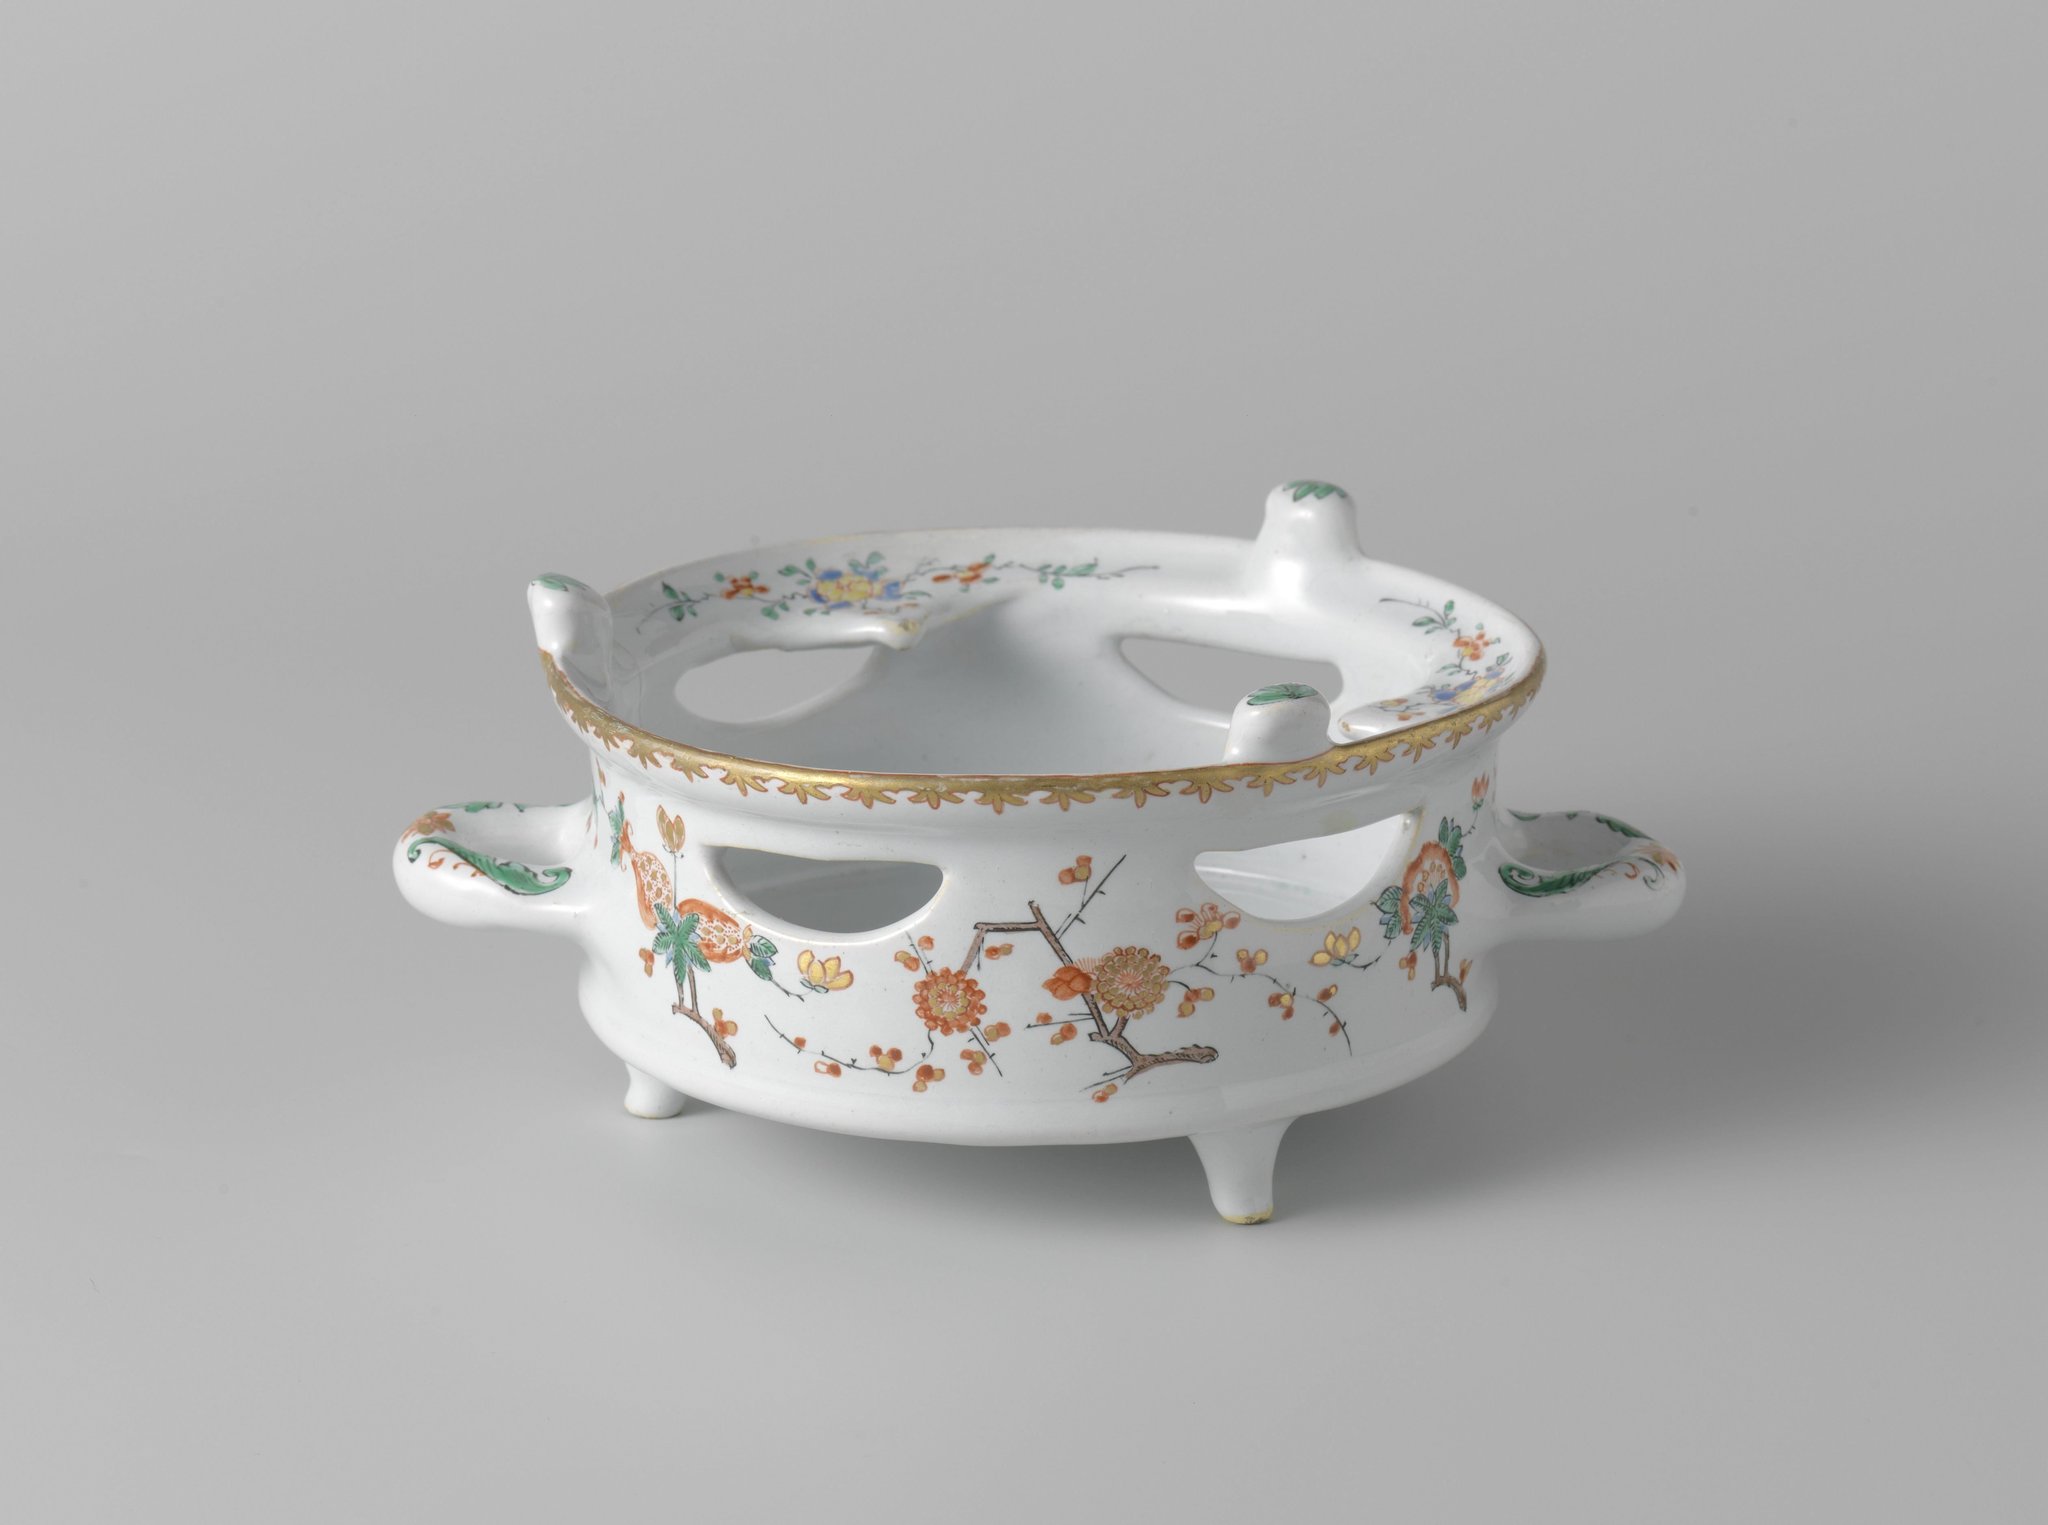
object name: komfoor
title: Komfoor met Kakiemon-decor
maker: Anonymous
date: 1740-1760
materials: earthenware, glaze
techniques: painted, polychromy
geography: delft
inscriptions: collector's mark: ‘Collectie Westendorp 94’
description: Stand Delftware, decorated in petit-feu Delft, c. 1740 - 1760